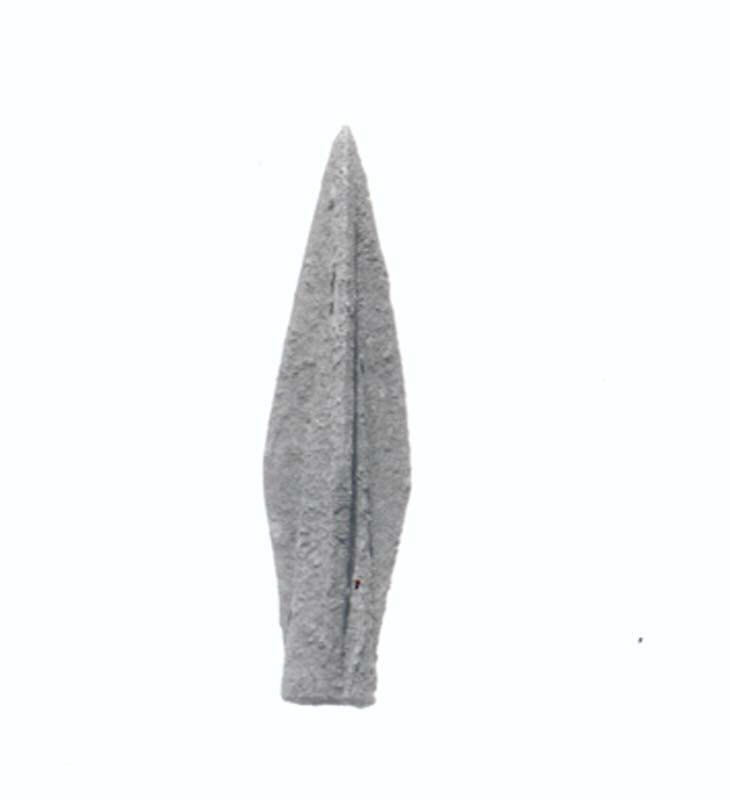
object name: arrowhead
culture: sasanian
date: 201-700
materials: iron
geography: iran